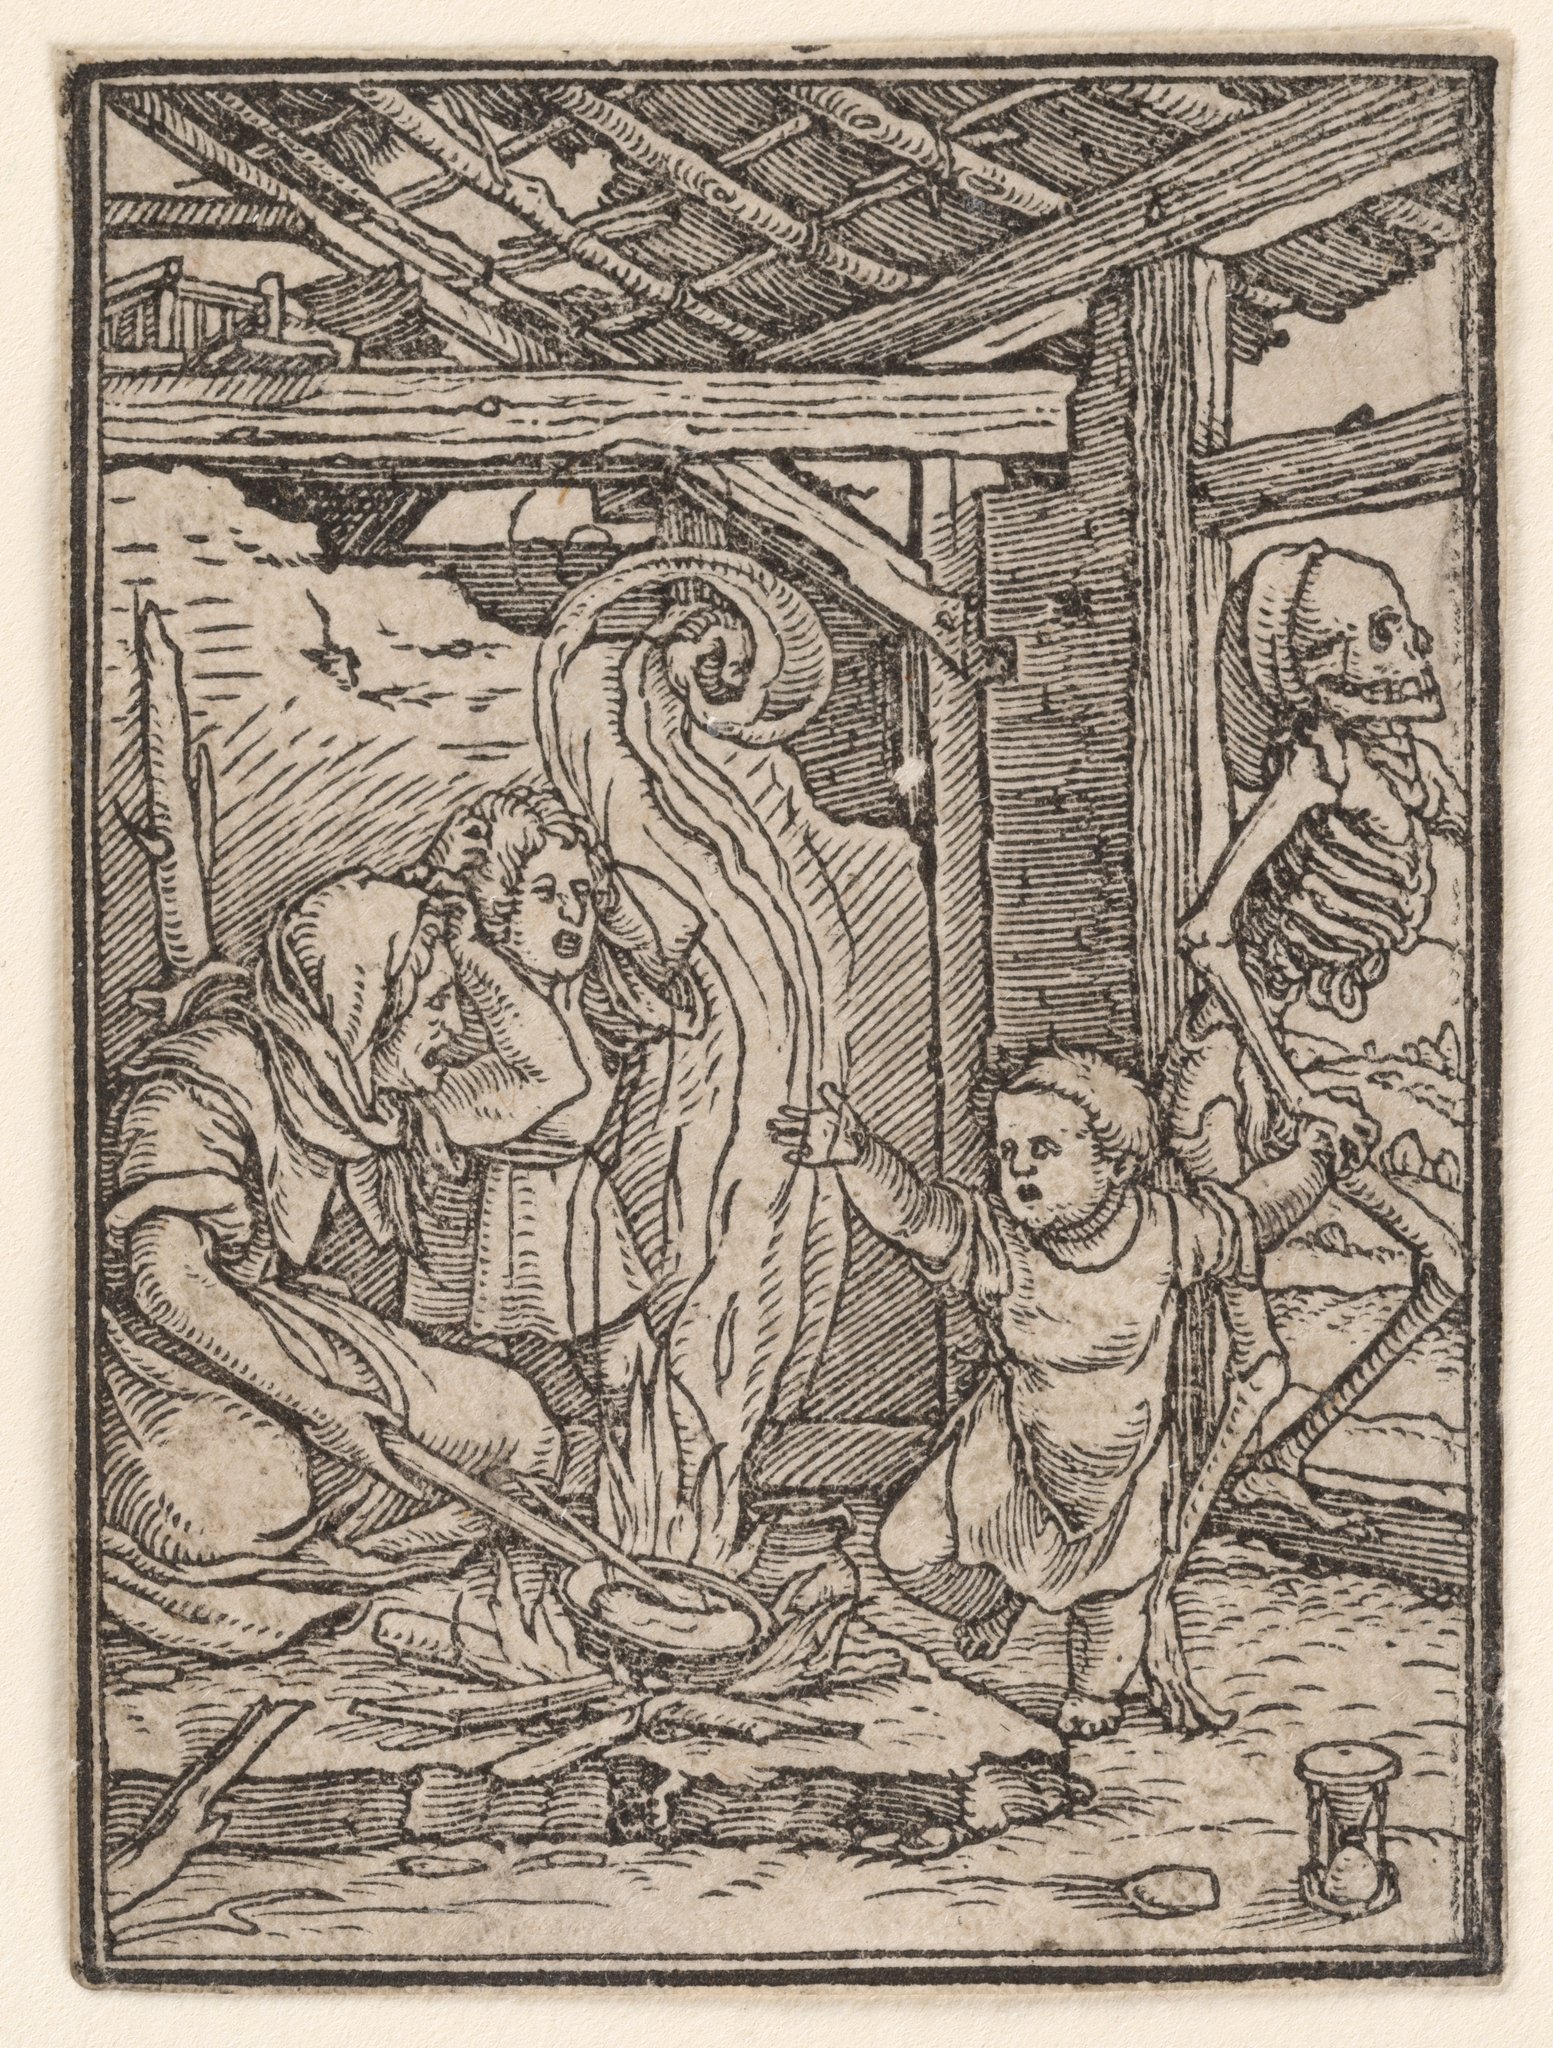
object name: print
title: The Child, from "The Dance of Death"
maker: hans holbein the younger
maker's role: artist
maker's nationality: german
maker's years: 1497-1543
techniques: woodcut